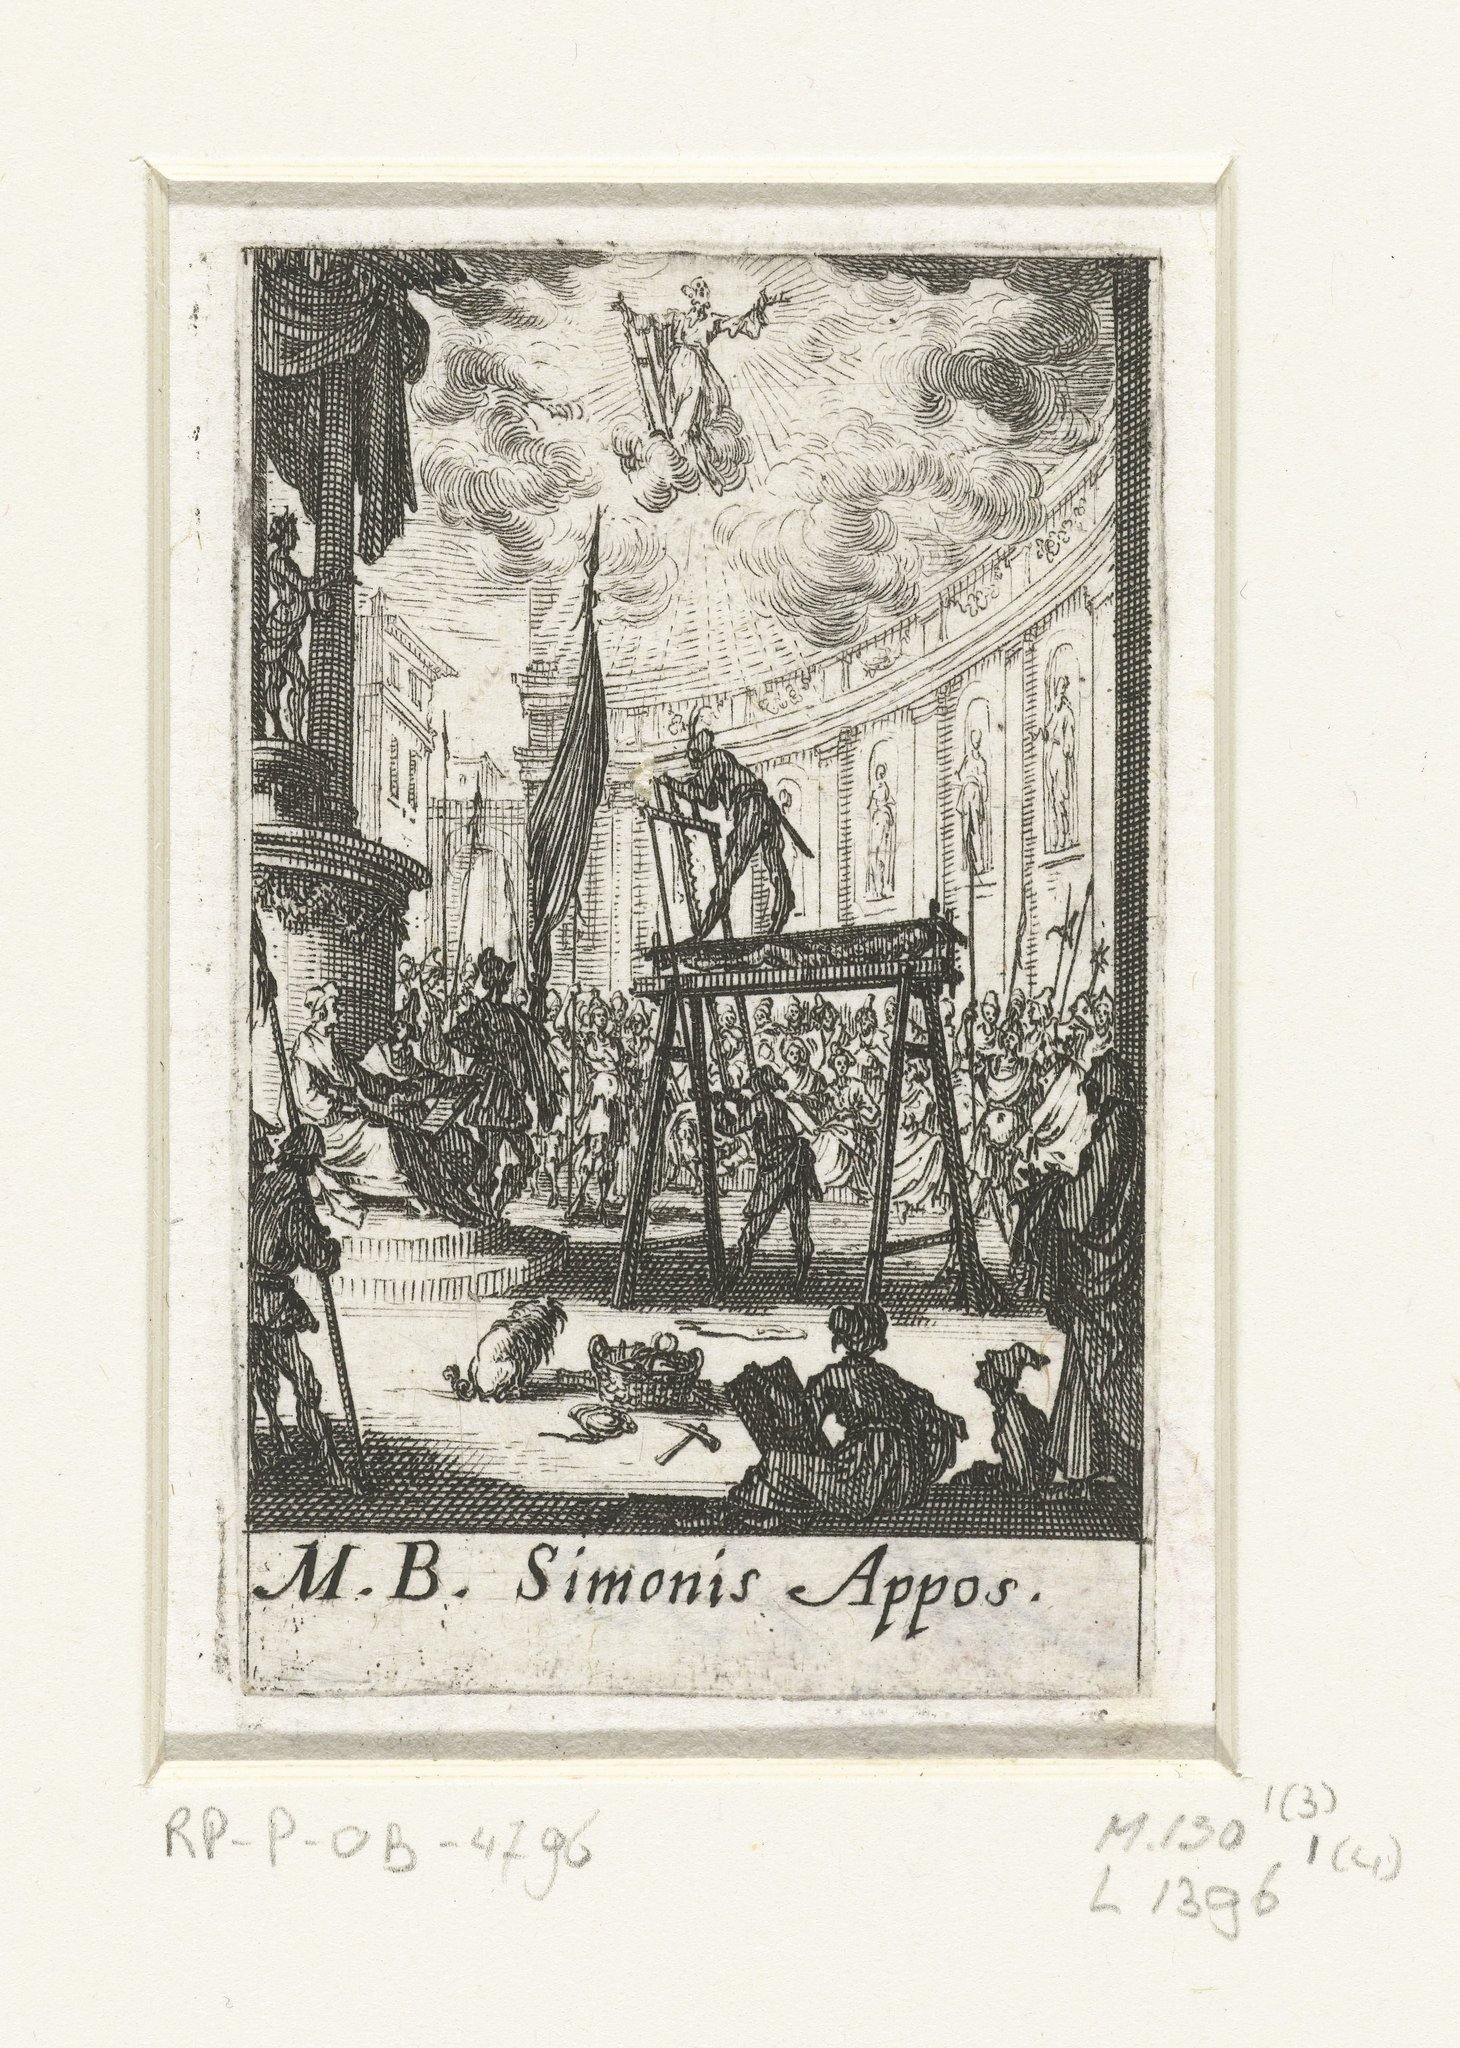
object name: print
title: De kleine apostelen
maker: jacques callot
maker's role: draughtsman, print maker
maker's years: 1592-1635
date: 1632-1634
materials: paper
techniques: etching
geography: nancy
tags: martyrdom and death of simon zelotes: he is sawn in two, or beaten to death, the apostle simon zelotes (or simon the canaanite); possible attributes: book, saw, scroll - martyrdom, suffering, misfortune, death of male saint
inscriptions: collector's mark: Lugt 240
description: Simon wordt door midden gezaagd in het bijzijn van vele toeschouwers. Boven deze scène is Simon nogmaals afgebeeld, op een wolk in de hemel, een zaag in de hand. Onder de voorstelling een onderschrift in Latijn. Deze prent is onderdeel van een reeks van 16 prenten, bestaande uit een titelblad en 15 voorstellingen van de martelingen die de apostelen hebben ondergaan.